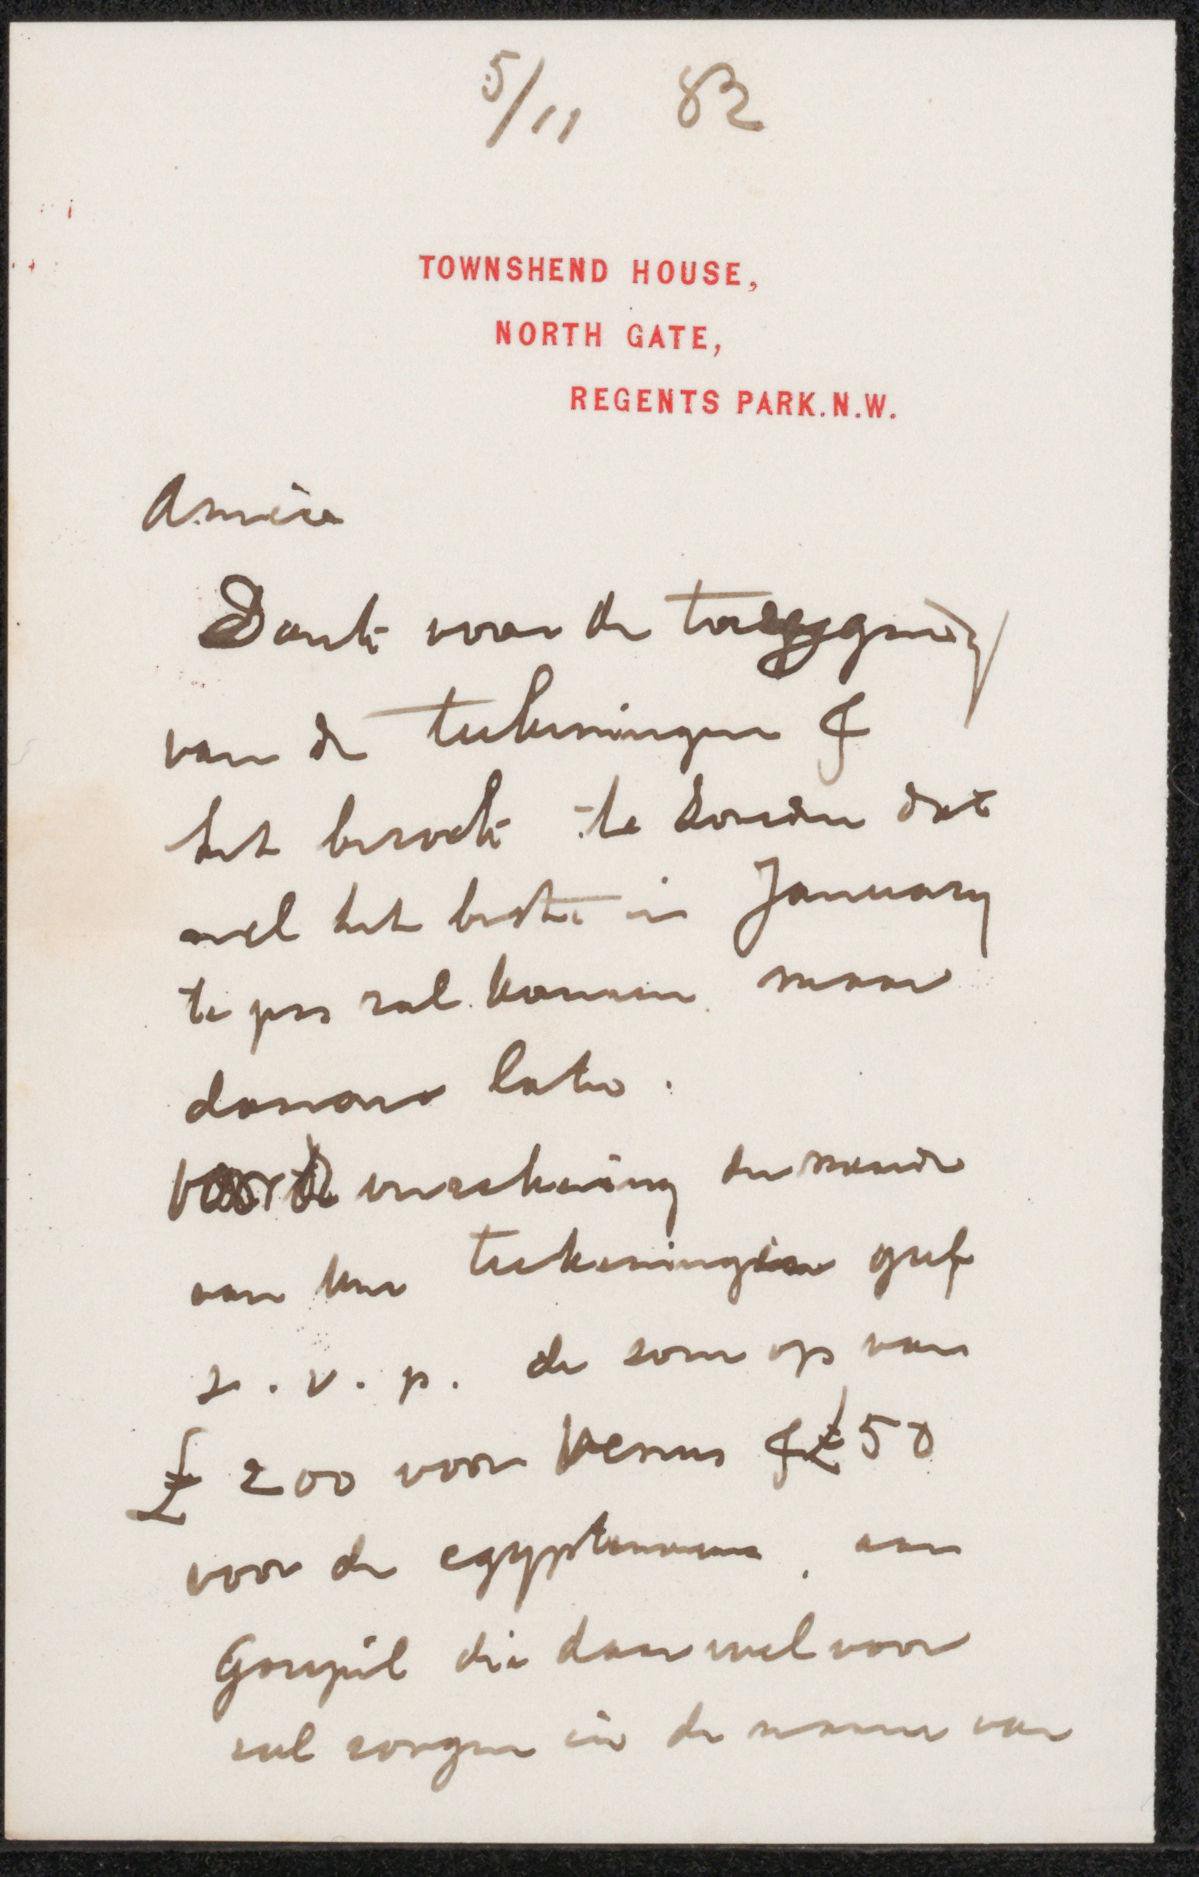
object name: letter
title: Brief aan Carel Vosmaer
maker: lourens alma tadema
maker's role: draughtsman, print maker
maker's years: 1836-1912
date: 1882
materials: ink, paper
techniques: pen, printing, writing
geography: london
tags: london, painter, carel vosmaer, printer, publisher, drawing, money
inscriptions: watermark